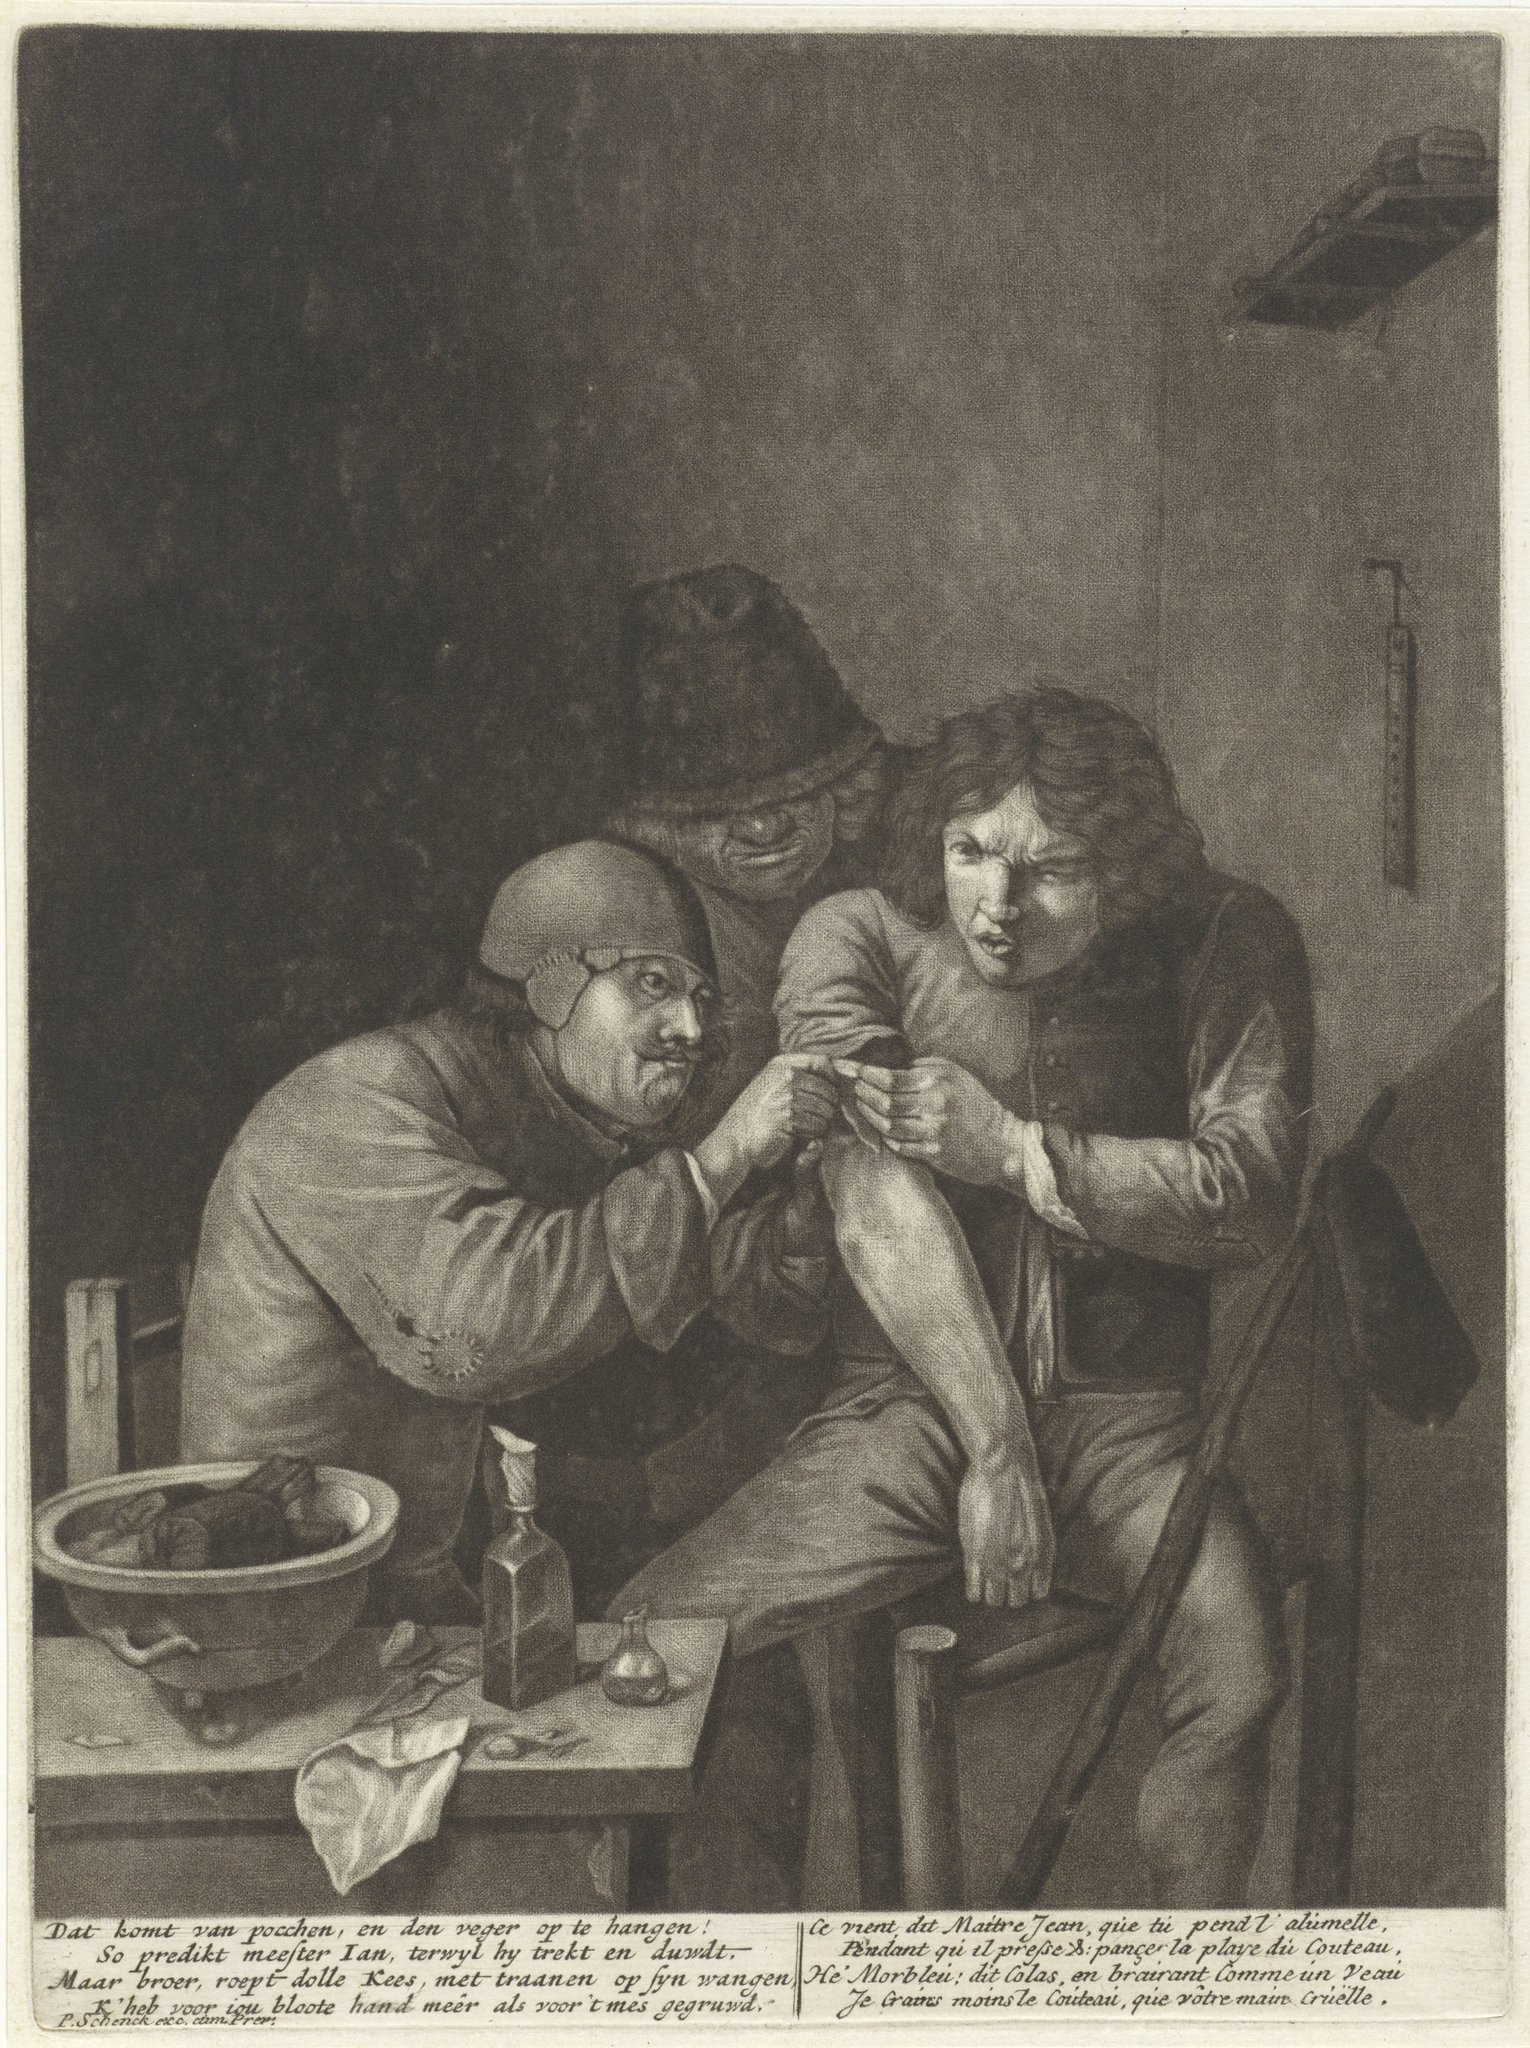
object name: print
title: Armoperatie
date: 1680-1713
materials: paper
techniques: engraving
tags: operation, surgery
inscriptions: collector's mark: Lugt 2228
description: Een man wordt aan zijn bovenarm geopereerd. Hij trekt een gepijnigd gezicht. Een derde man kijkt toe.